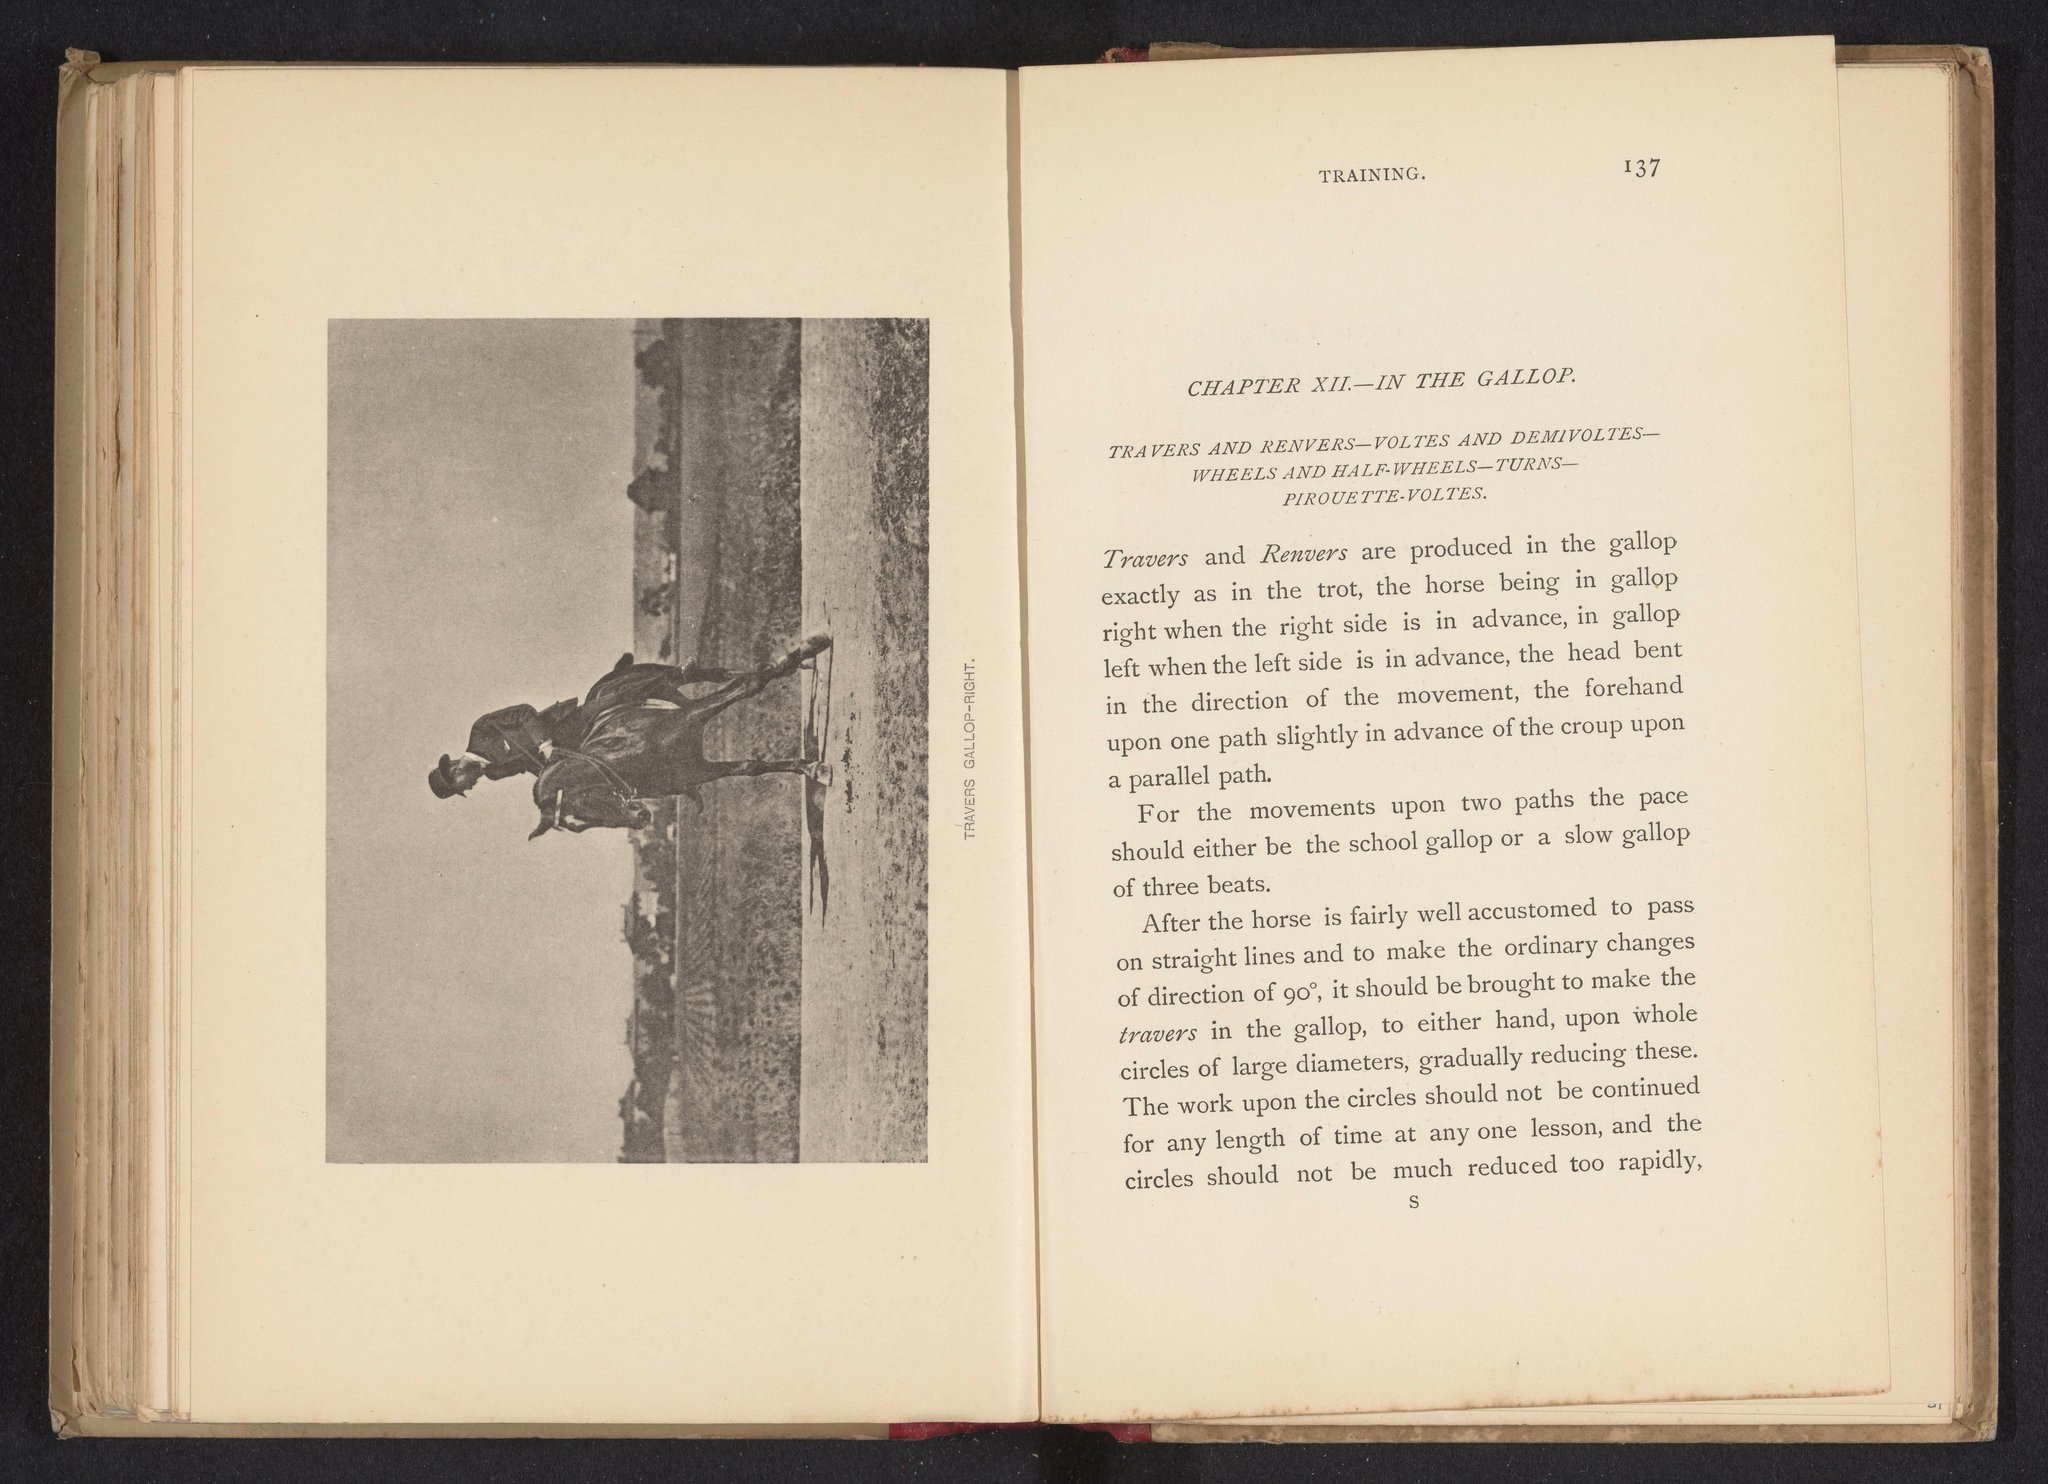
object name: photomechanical print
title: Man op een paard in zijwaartse galop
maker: Anonymous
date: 1879-1889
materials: paper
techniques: photograph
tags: riding a horse, ass, or mule; rider, horseman, head-gear: bowler hat, galloping horse